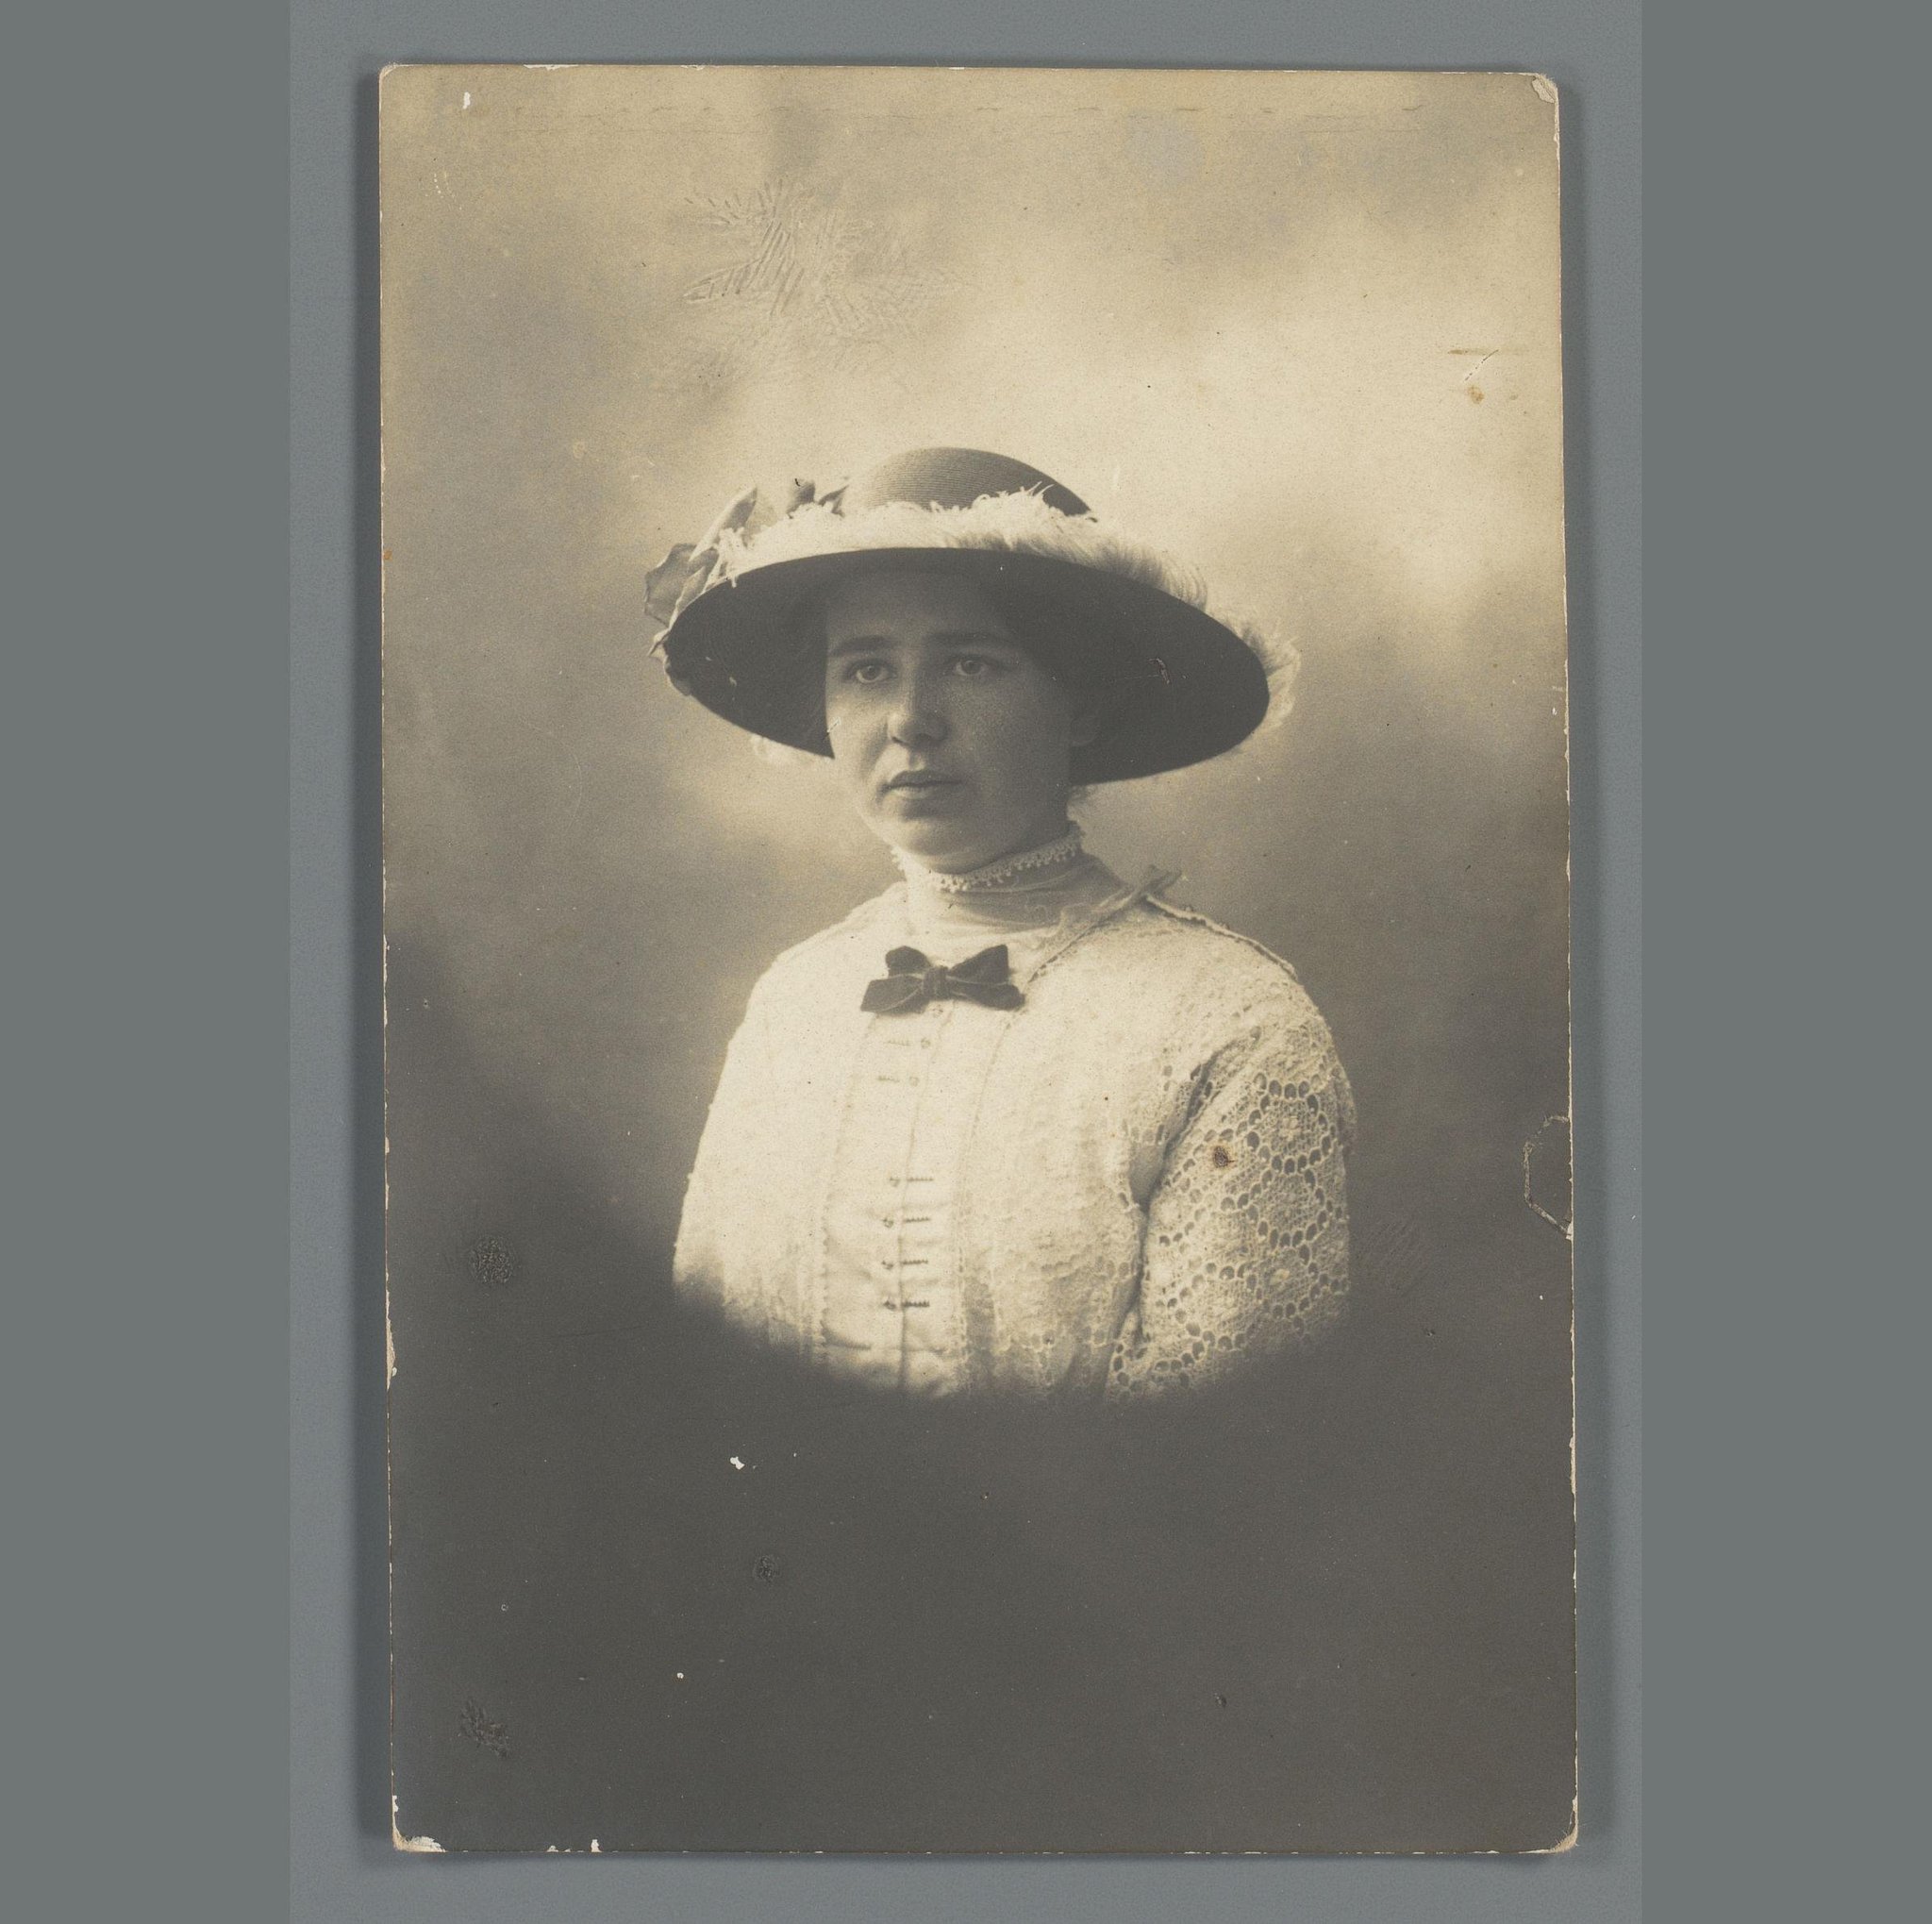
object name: ansichtkaart, prentbriefkaart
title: Portret van een onbekende jonge vrouw met hoed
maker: lambertus van der feer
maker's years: 1867-1920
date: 1905-1918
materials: paper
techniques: gelatin silver print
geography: sneek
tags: historical persons not known by name - bb - woman, head-gear: hat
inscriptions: inscription: ‘L. van der Feer Pzn. Fotograaf, Sneek-Bolsward.’, number: ‘18’